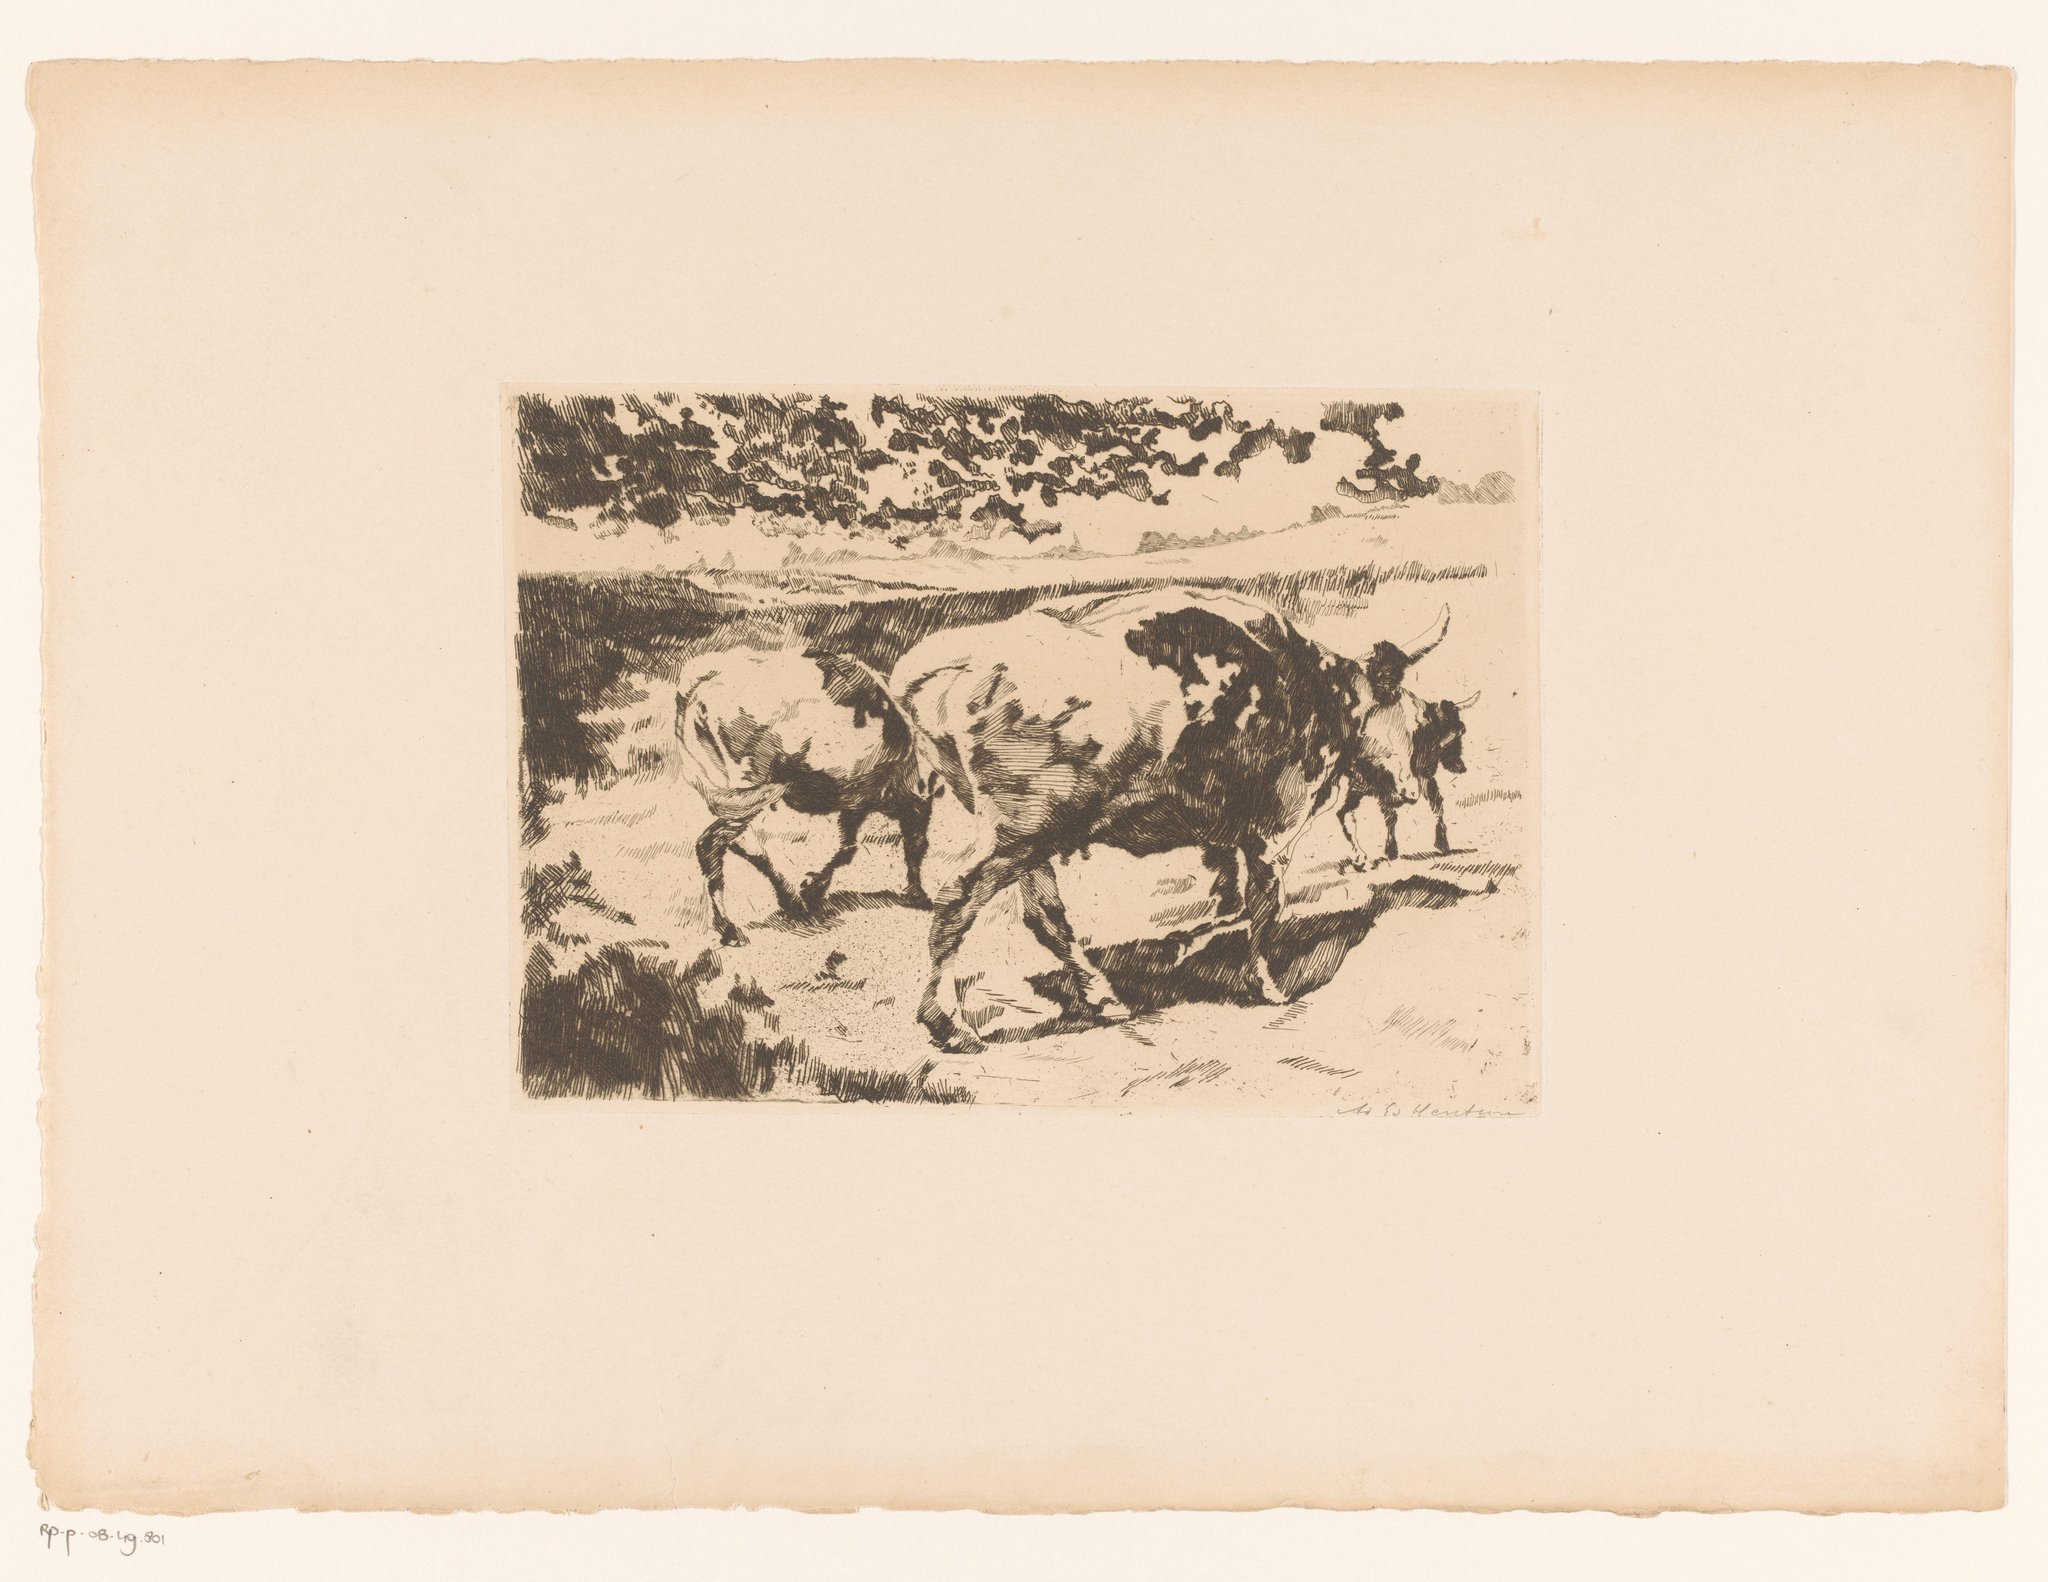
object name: print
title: Runderen in de weide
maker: adolf eduard herstein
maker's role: print maker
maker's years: 1869-1932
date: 1879-1932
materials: paper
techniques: drypoint, etching, intaglio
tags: bovine cattle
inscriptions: collector's mark: Lugt 2228